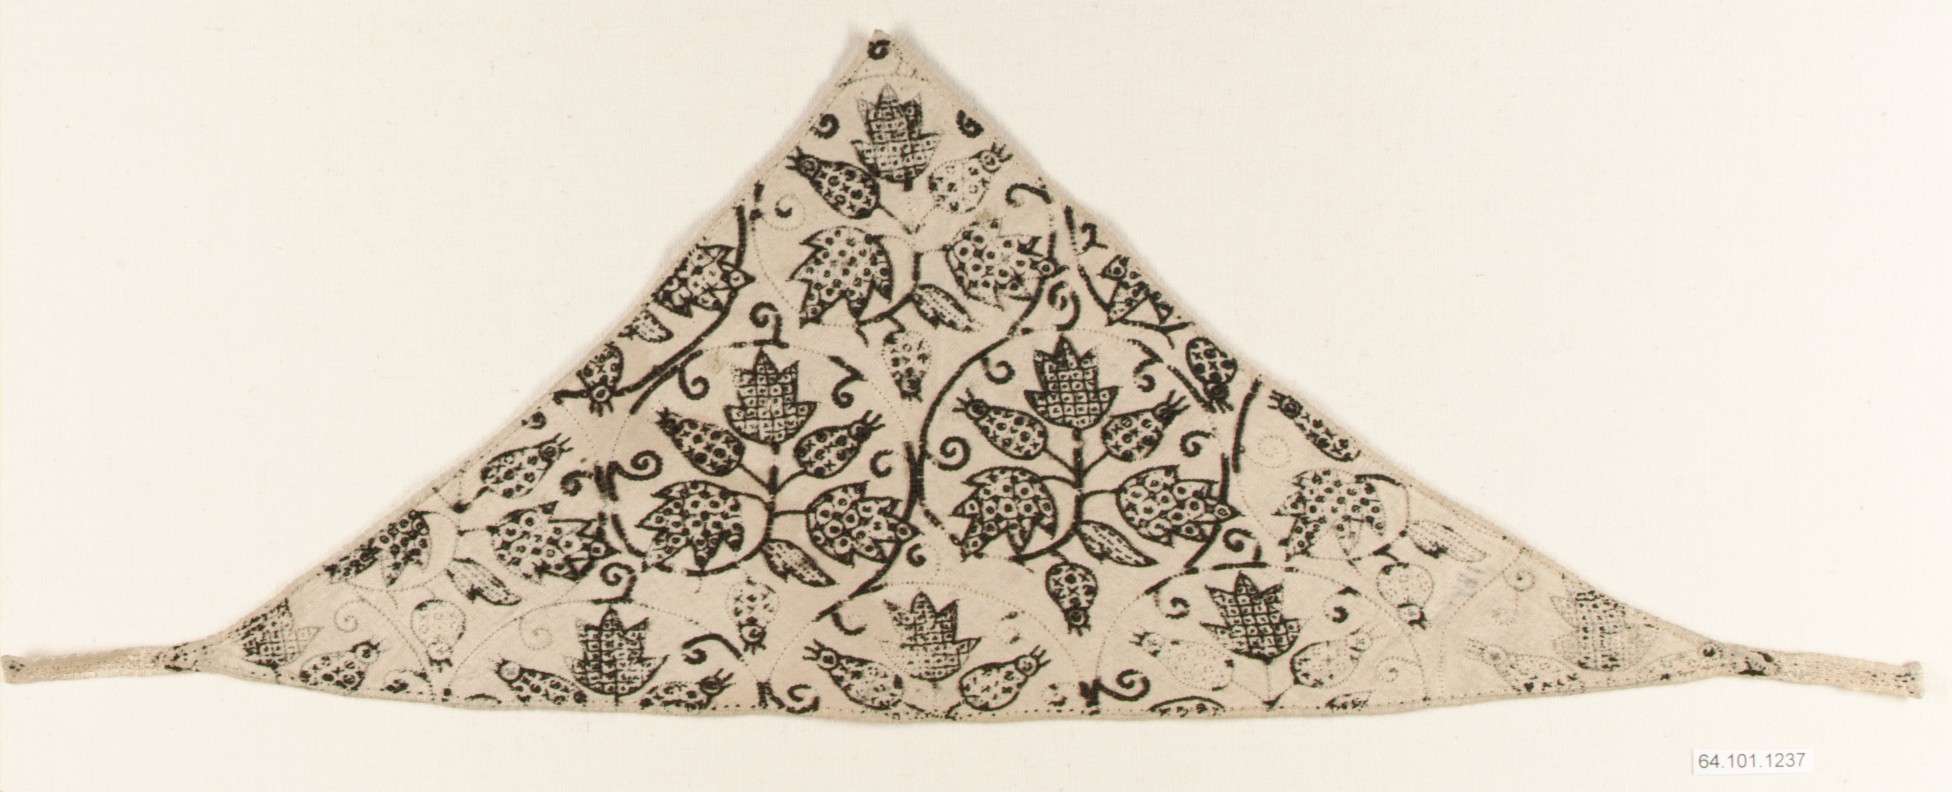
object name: forehead cloth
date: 1576-1600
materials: linen, silk